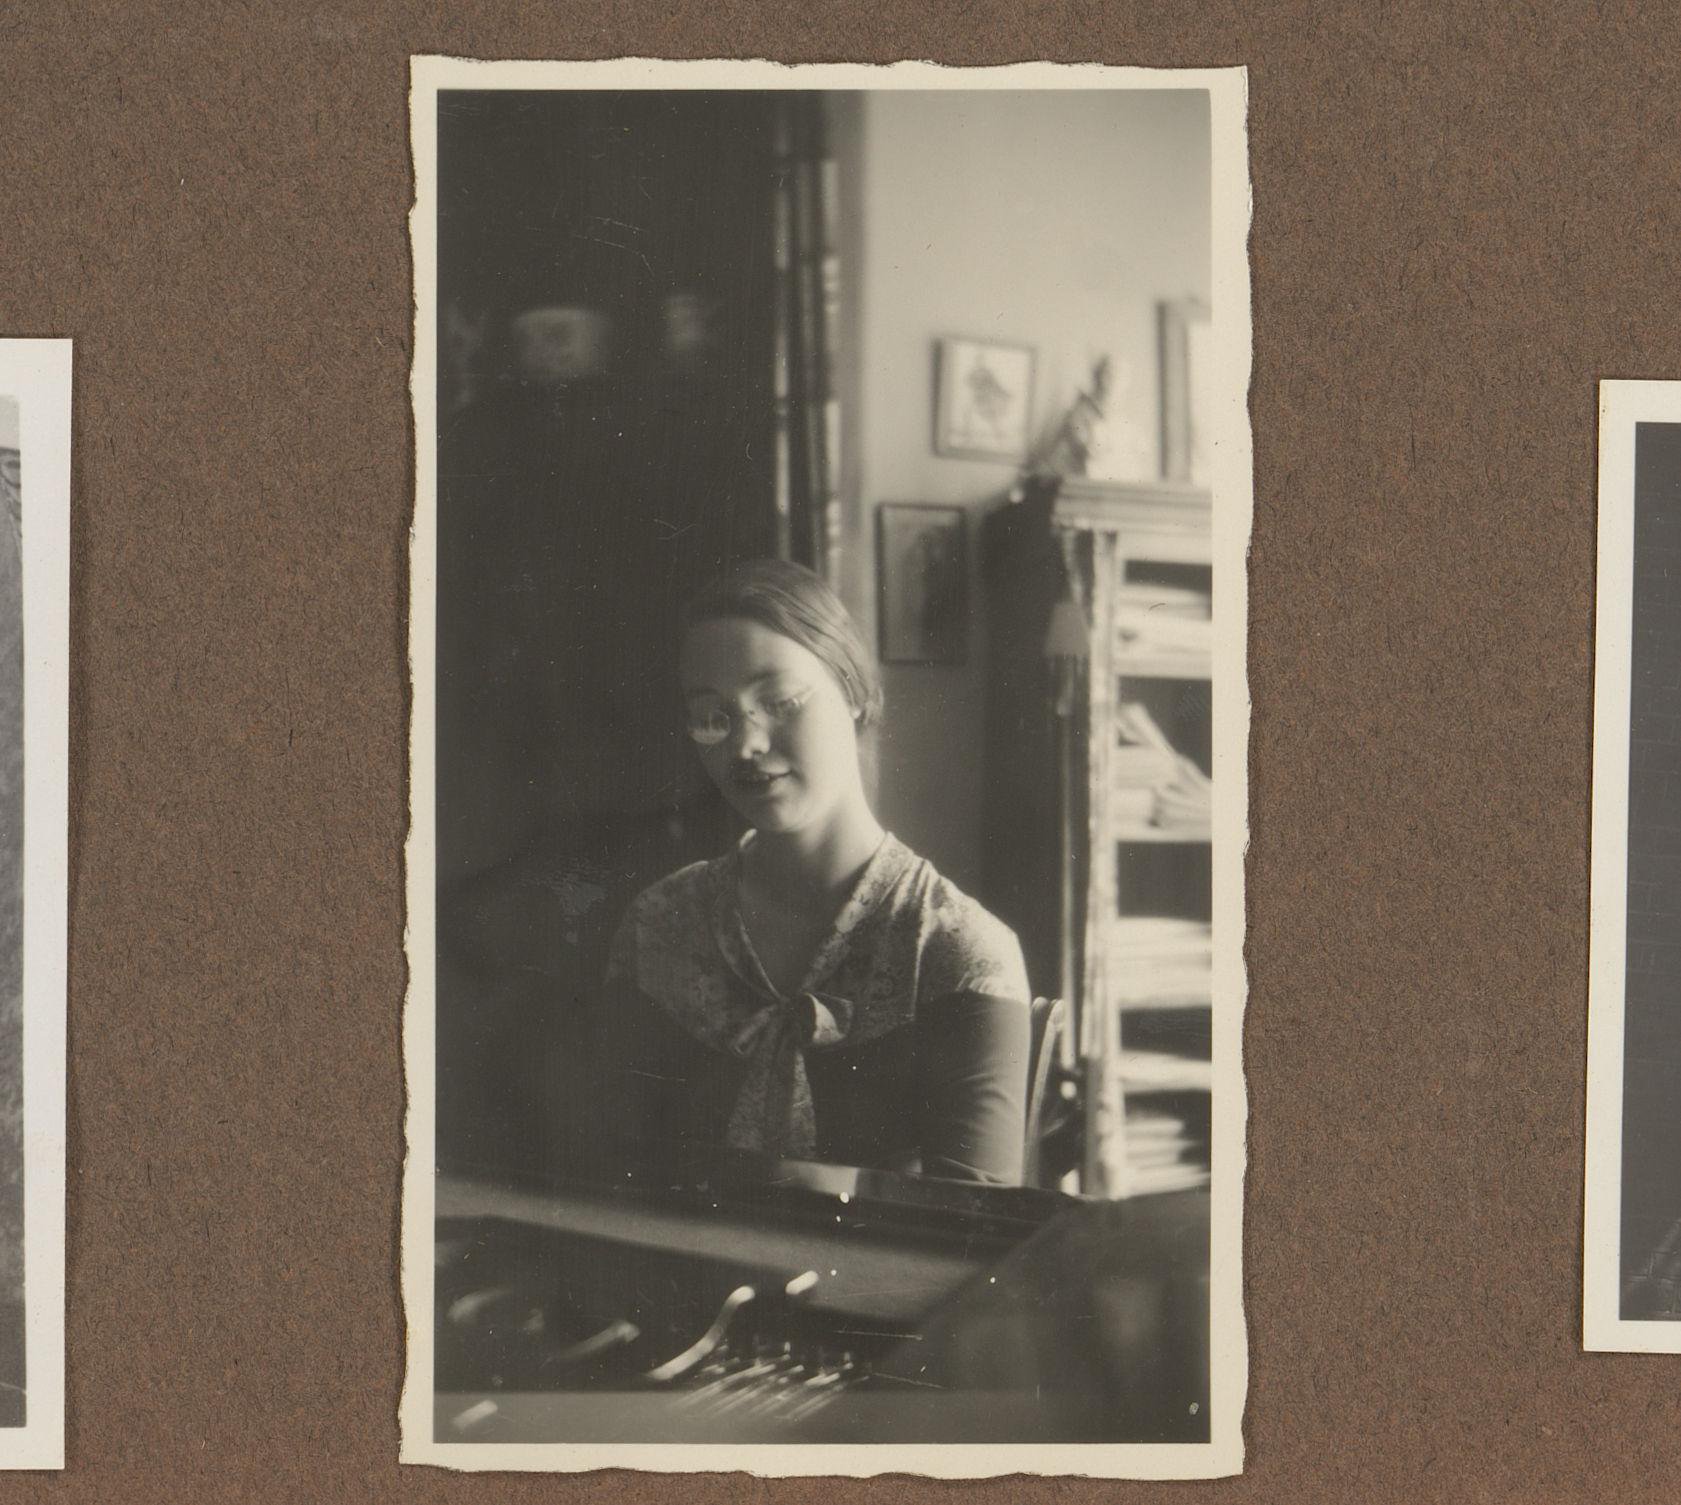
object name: photograph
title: Jonge vrouw aan de piano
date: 1900-1920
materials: photographic support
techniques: photography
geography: amsterdam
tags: netherlands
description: Foto op bruin albumblad 53 van familiealbum van Alphons Diepenbrock.